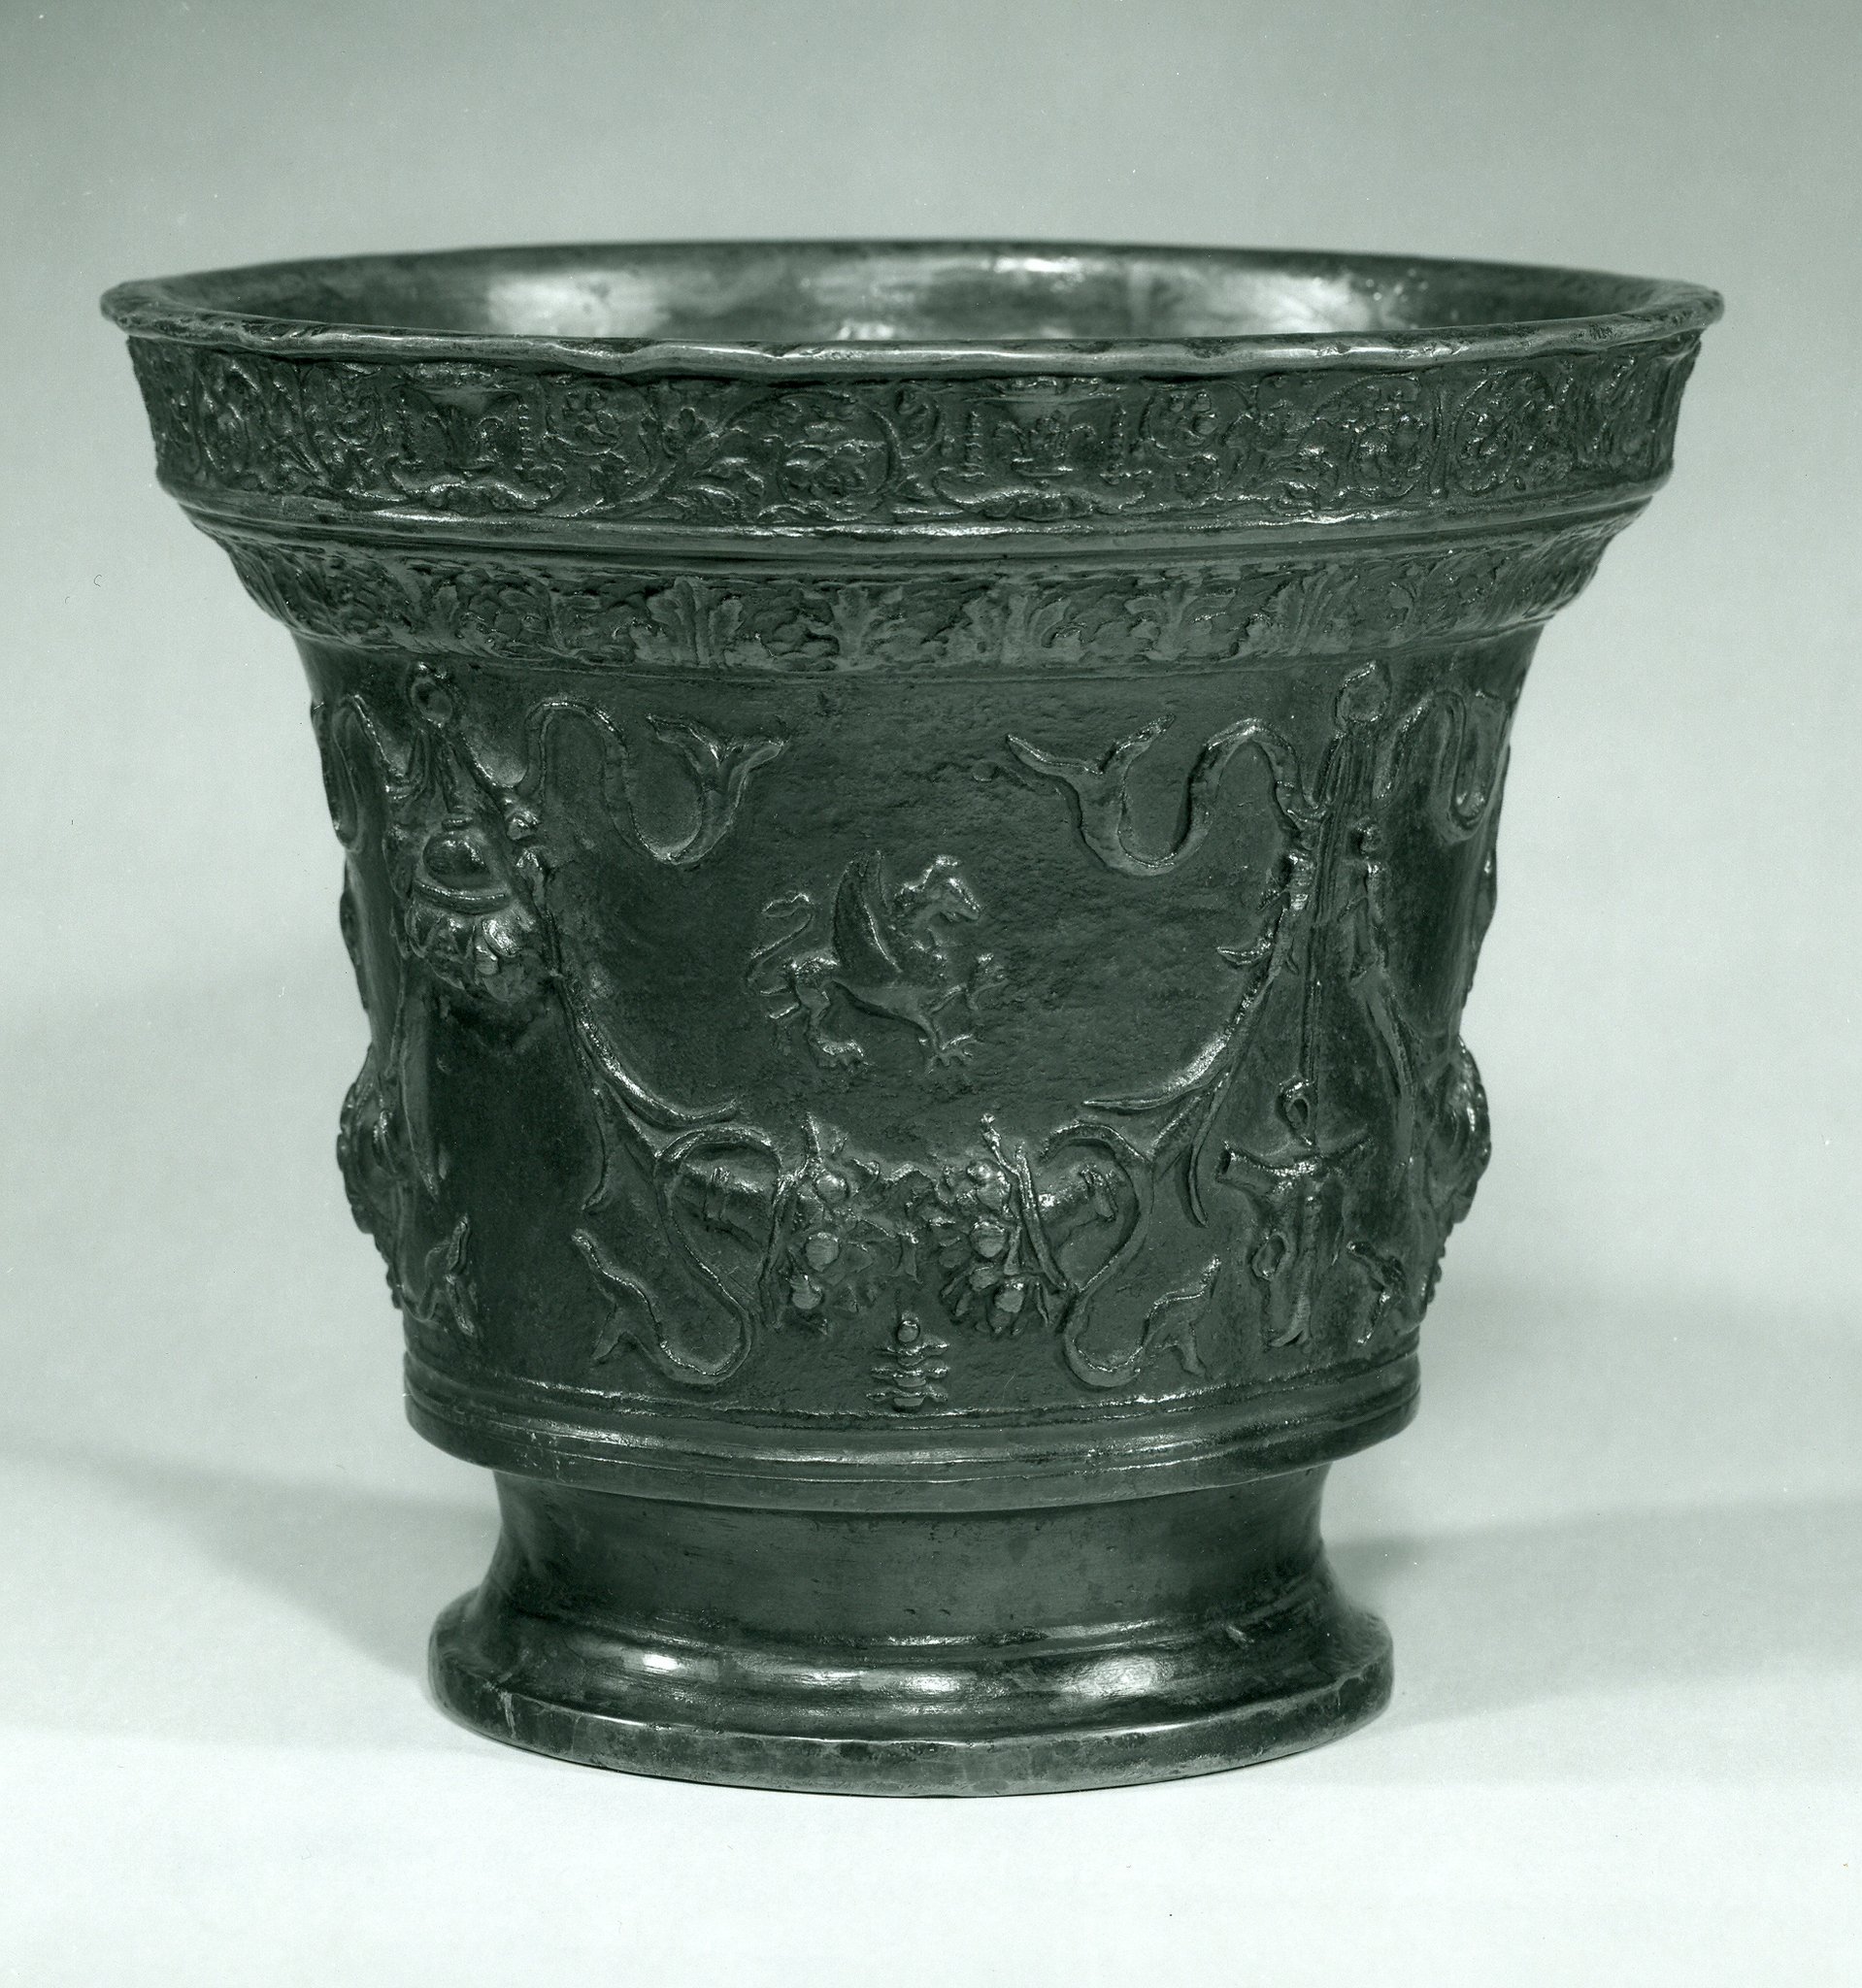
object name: mortar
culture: italian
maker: alberghetti foundry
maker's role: artist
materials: alloy, copper, copper alloy, iron, lead, nickel, patina, silver, tin, zinc